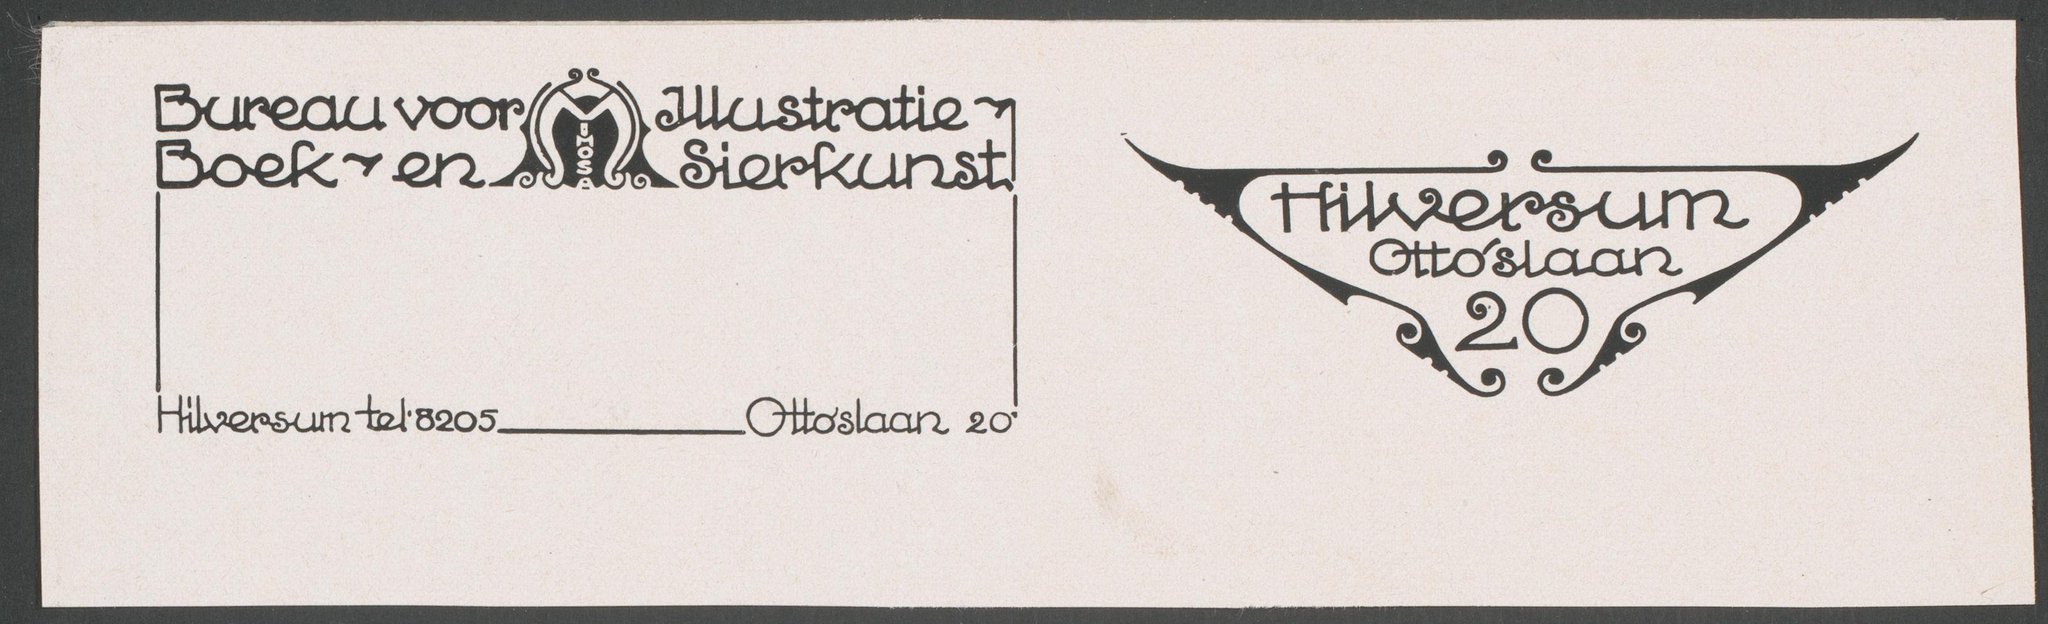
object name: photomechanical print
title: Ontwerpen voor vignetten van Bureau voor Illustratie, Boek- en Sierkunst Mimosa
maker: reinier willem petrus de vries (1874-1953)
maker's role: draughtsman, print maker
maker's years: 1874-1953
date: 1884-1952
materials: paper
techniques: printing block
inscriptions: collector's mark: ‘R:MVS.’